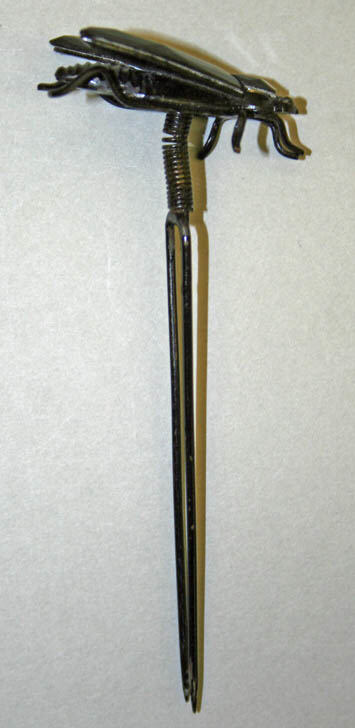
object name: hairpin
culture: american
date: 1870-1889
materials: glass, metal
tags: insects